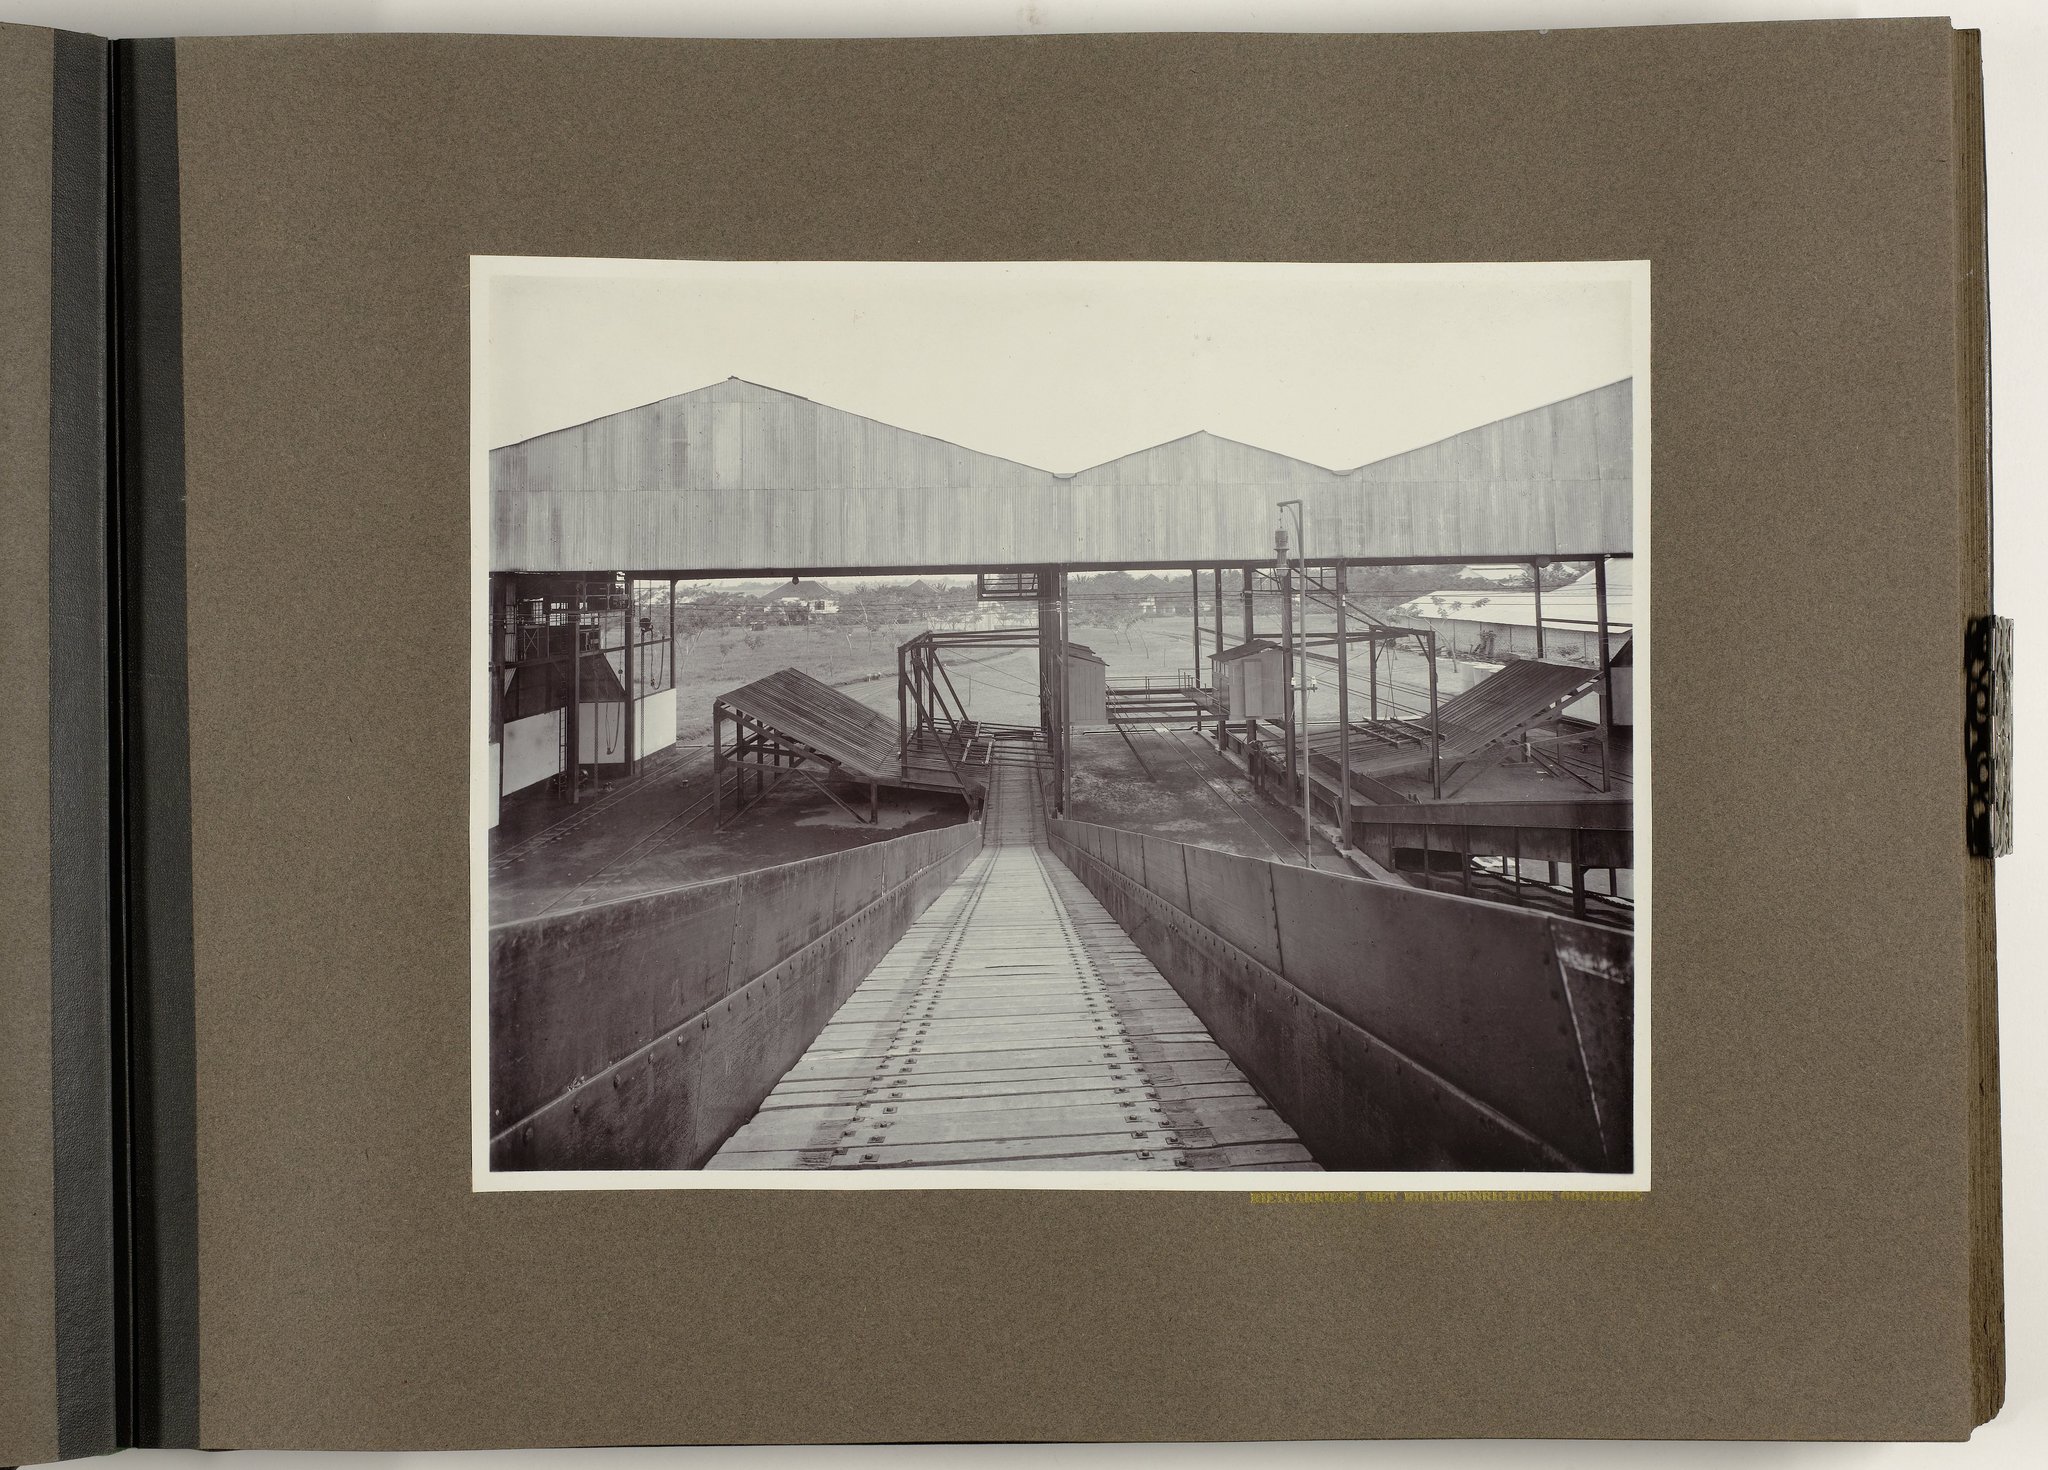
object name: photograph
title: Rietcarriers met rietlosinrichting oostzijde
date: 1917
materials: photographic support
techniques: gelatin silver print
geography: jatiroto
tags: colonial system, (non-fruit) products of plants or trees: sugarcane, exterior of industrial structures, factories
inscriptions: inscription: ‘RIETCARRIERS MET RIETLOSINRICHTING OOSTZIJDE’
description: Inrichting voor het lossen van treinwagons met suikerriet, gezien vanuit de rietcarriers. Onderdeel van het fotoalbum aangeboden aan F.J. Wirix door het personeel van de Suikeronderneming Djatiroto in 1917.